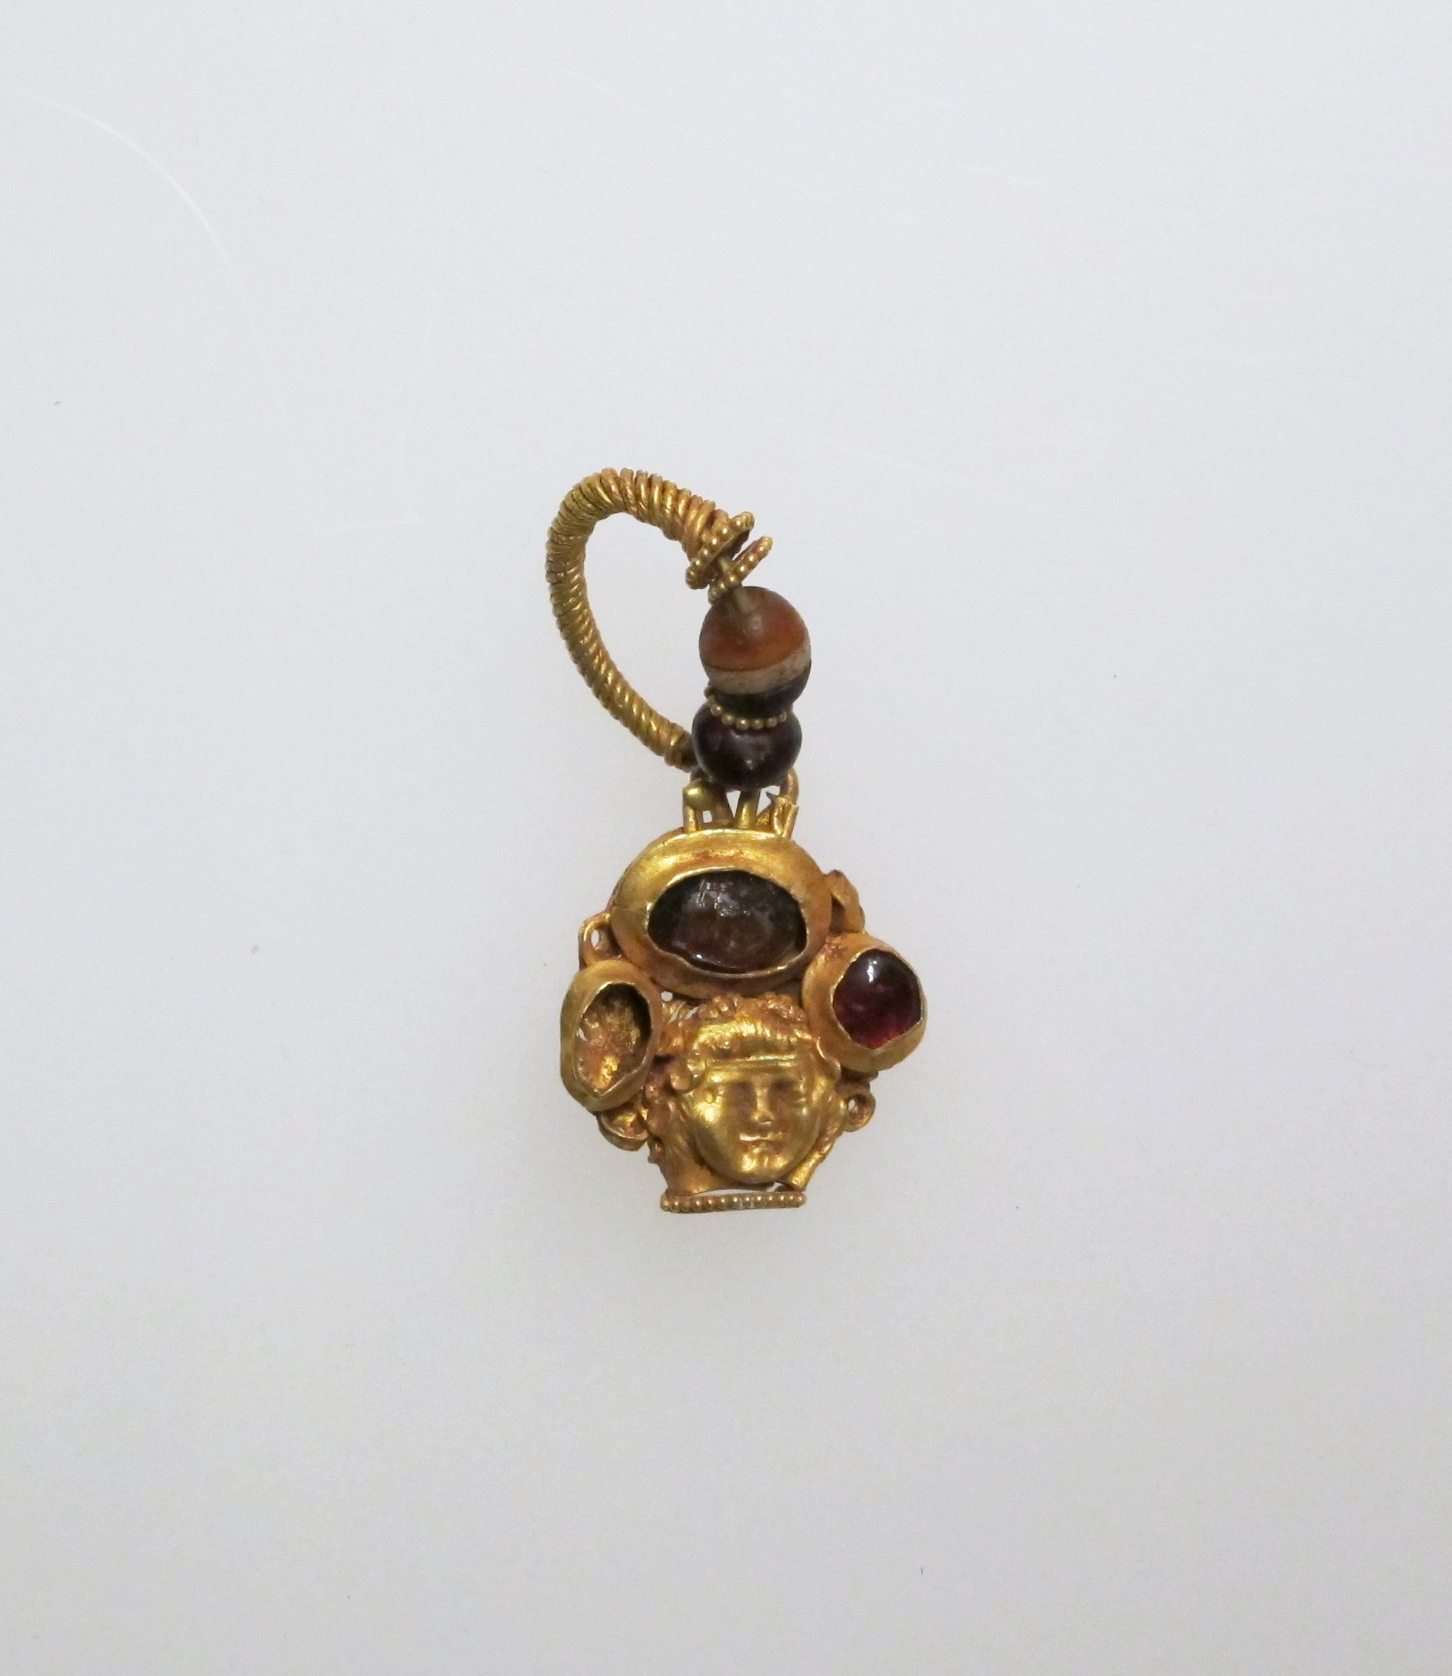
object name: earring with human face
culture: roman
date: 100 BCE-300 CE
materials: gemstone, gold